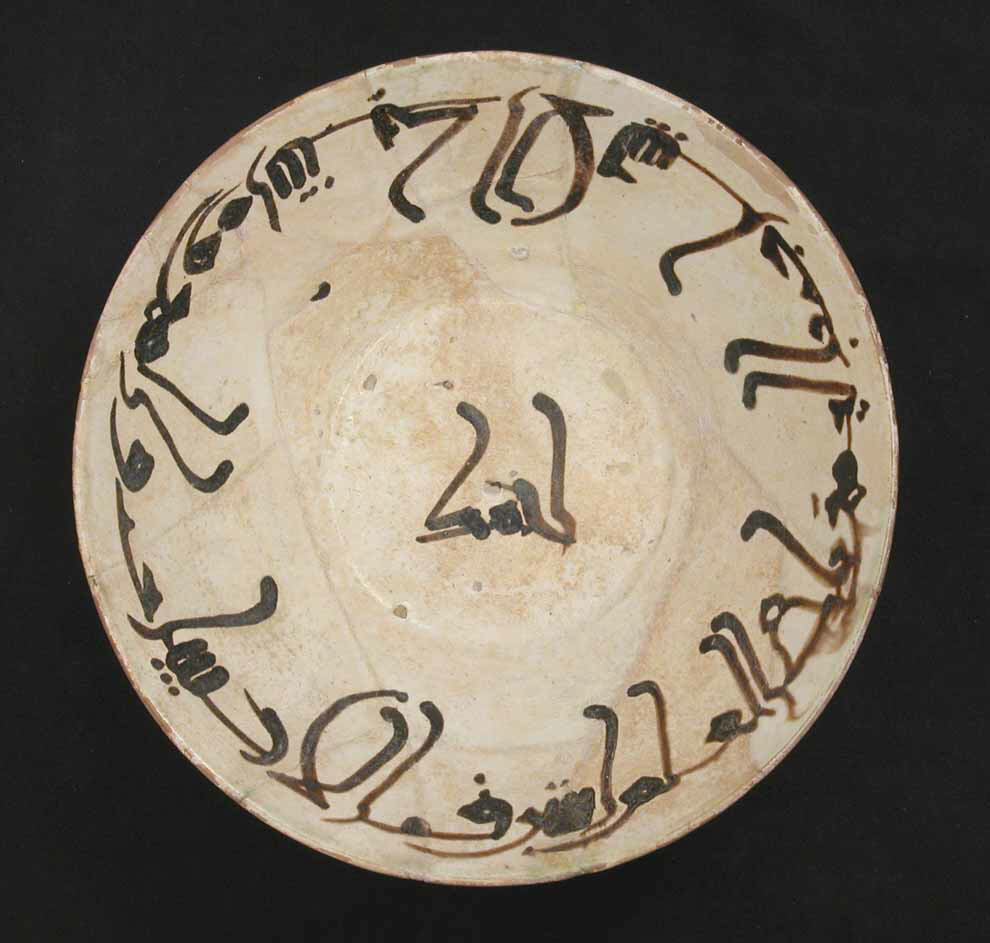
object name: bowl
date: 901-1000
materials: earthenware, glaze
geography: iran